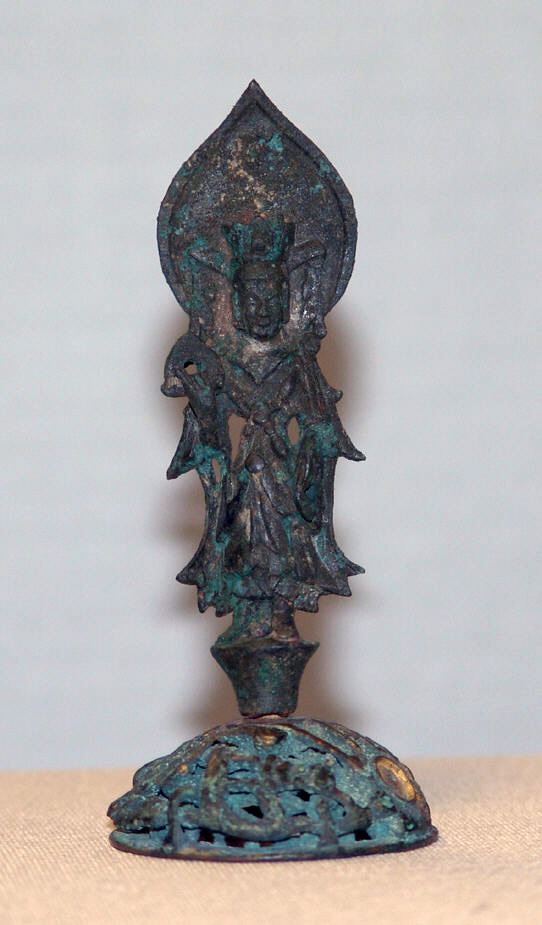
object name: figure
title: Bodhisattva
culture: chinese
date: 581-618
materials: bronze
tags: bodhisattvas